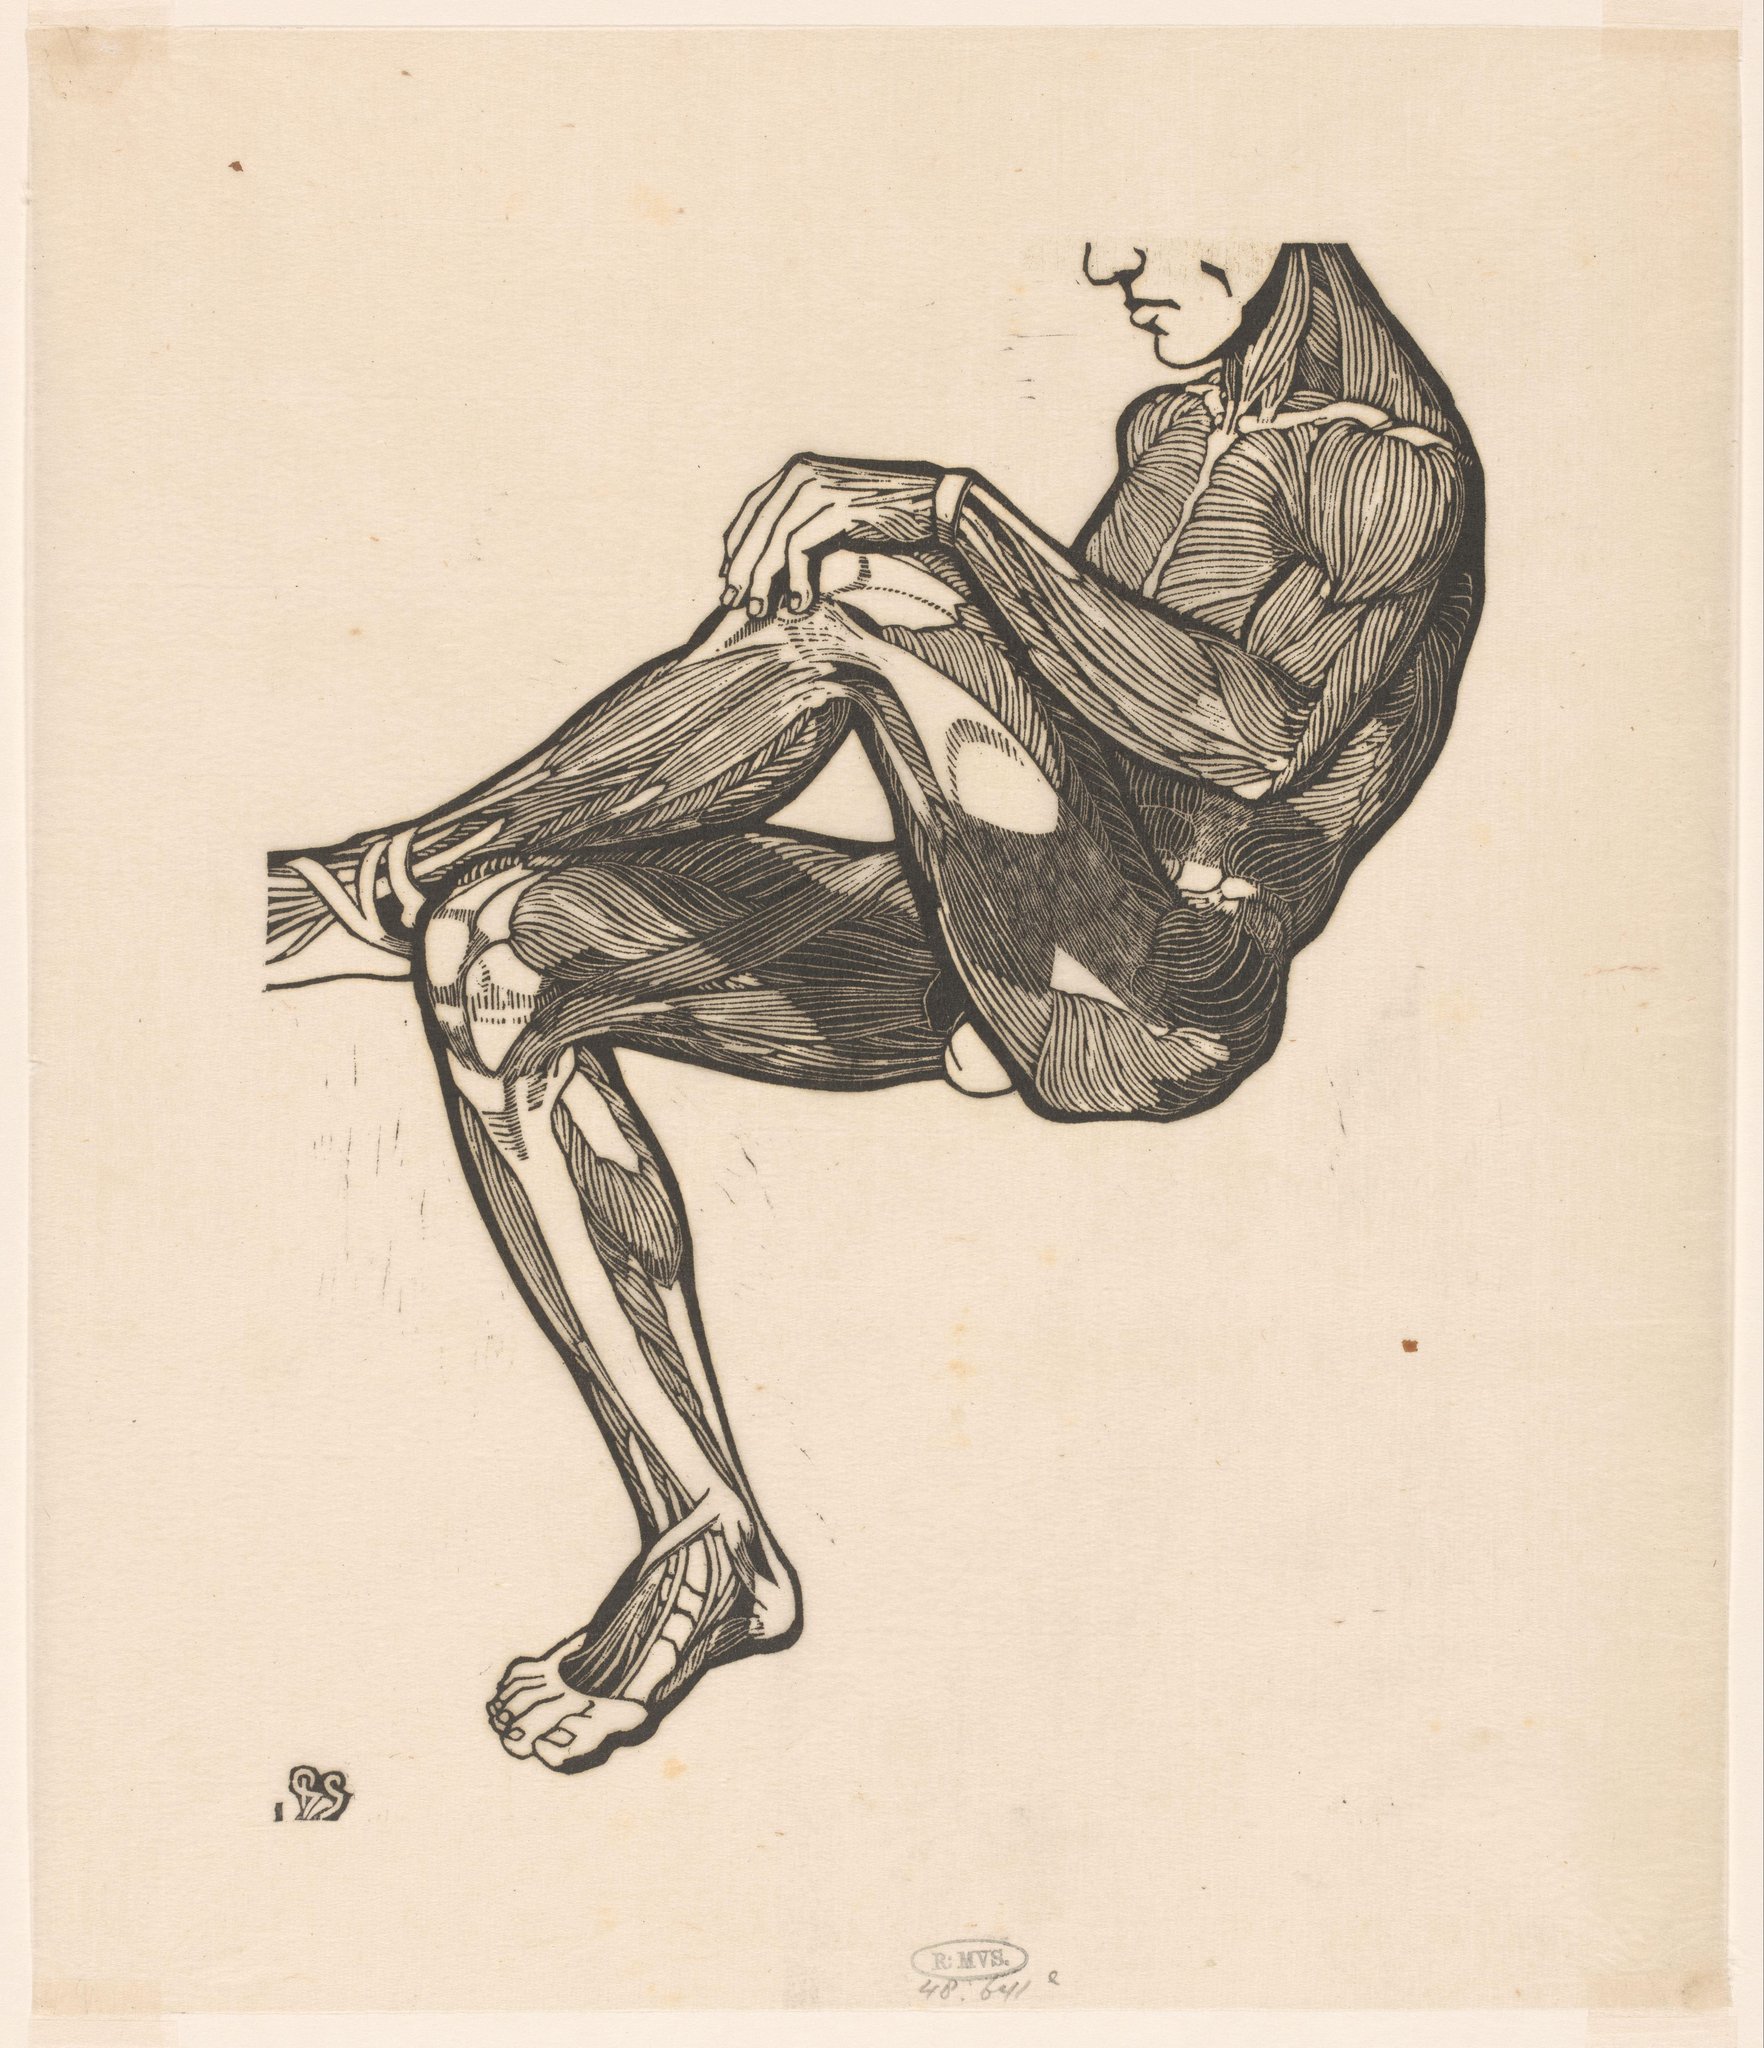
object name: print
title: Anatomische studie van de been- en armspieren van een man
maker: reijer stolk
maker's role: draughtsman, print maker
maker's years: 1896-1945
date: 1906-1945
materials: paper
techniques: woodcut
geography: netherlands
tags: anatomical model of the muscles, muscle-man, 'écorché'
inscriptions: collector's mark: Lugt 2228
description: Prent gebruikt voor: Stolk, Reyer. Anatomische studies in houtsneden. Amsterdam: G.W. Breughel, 1946, plaat 4.